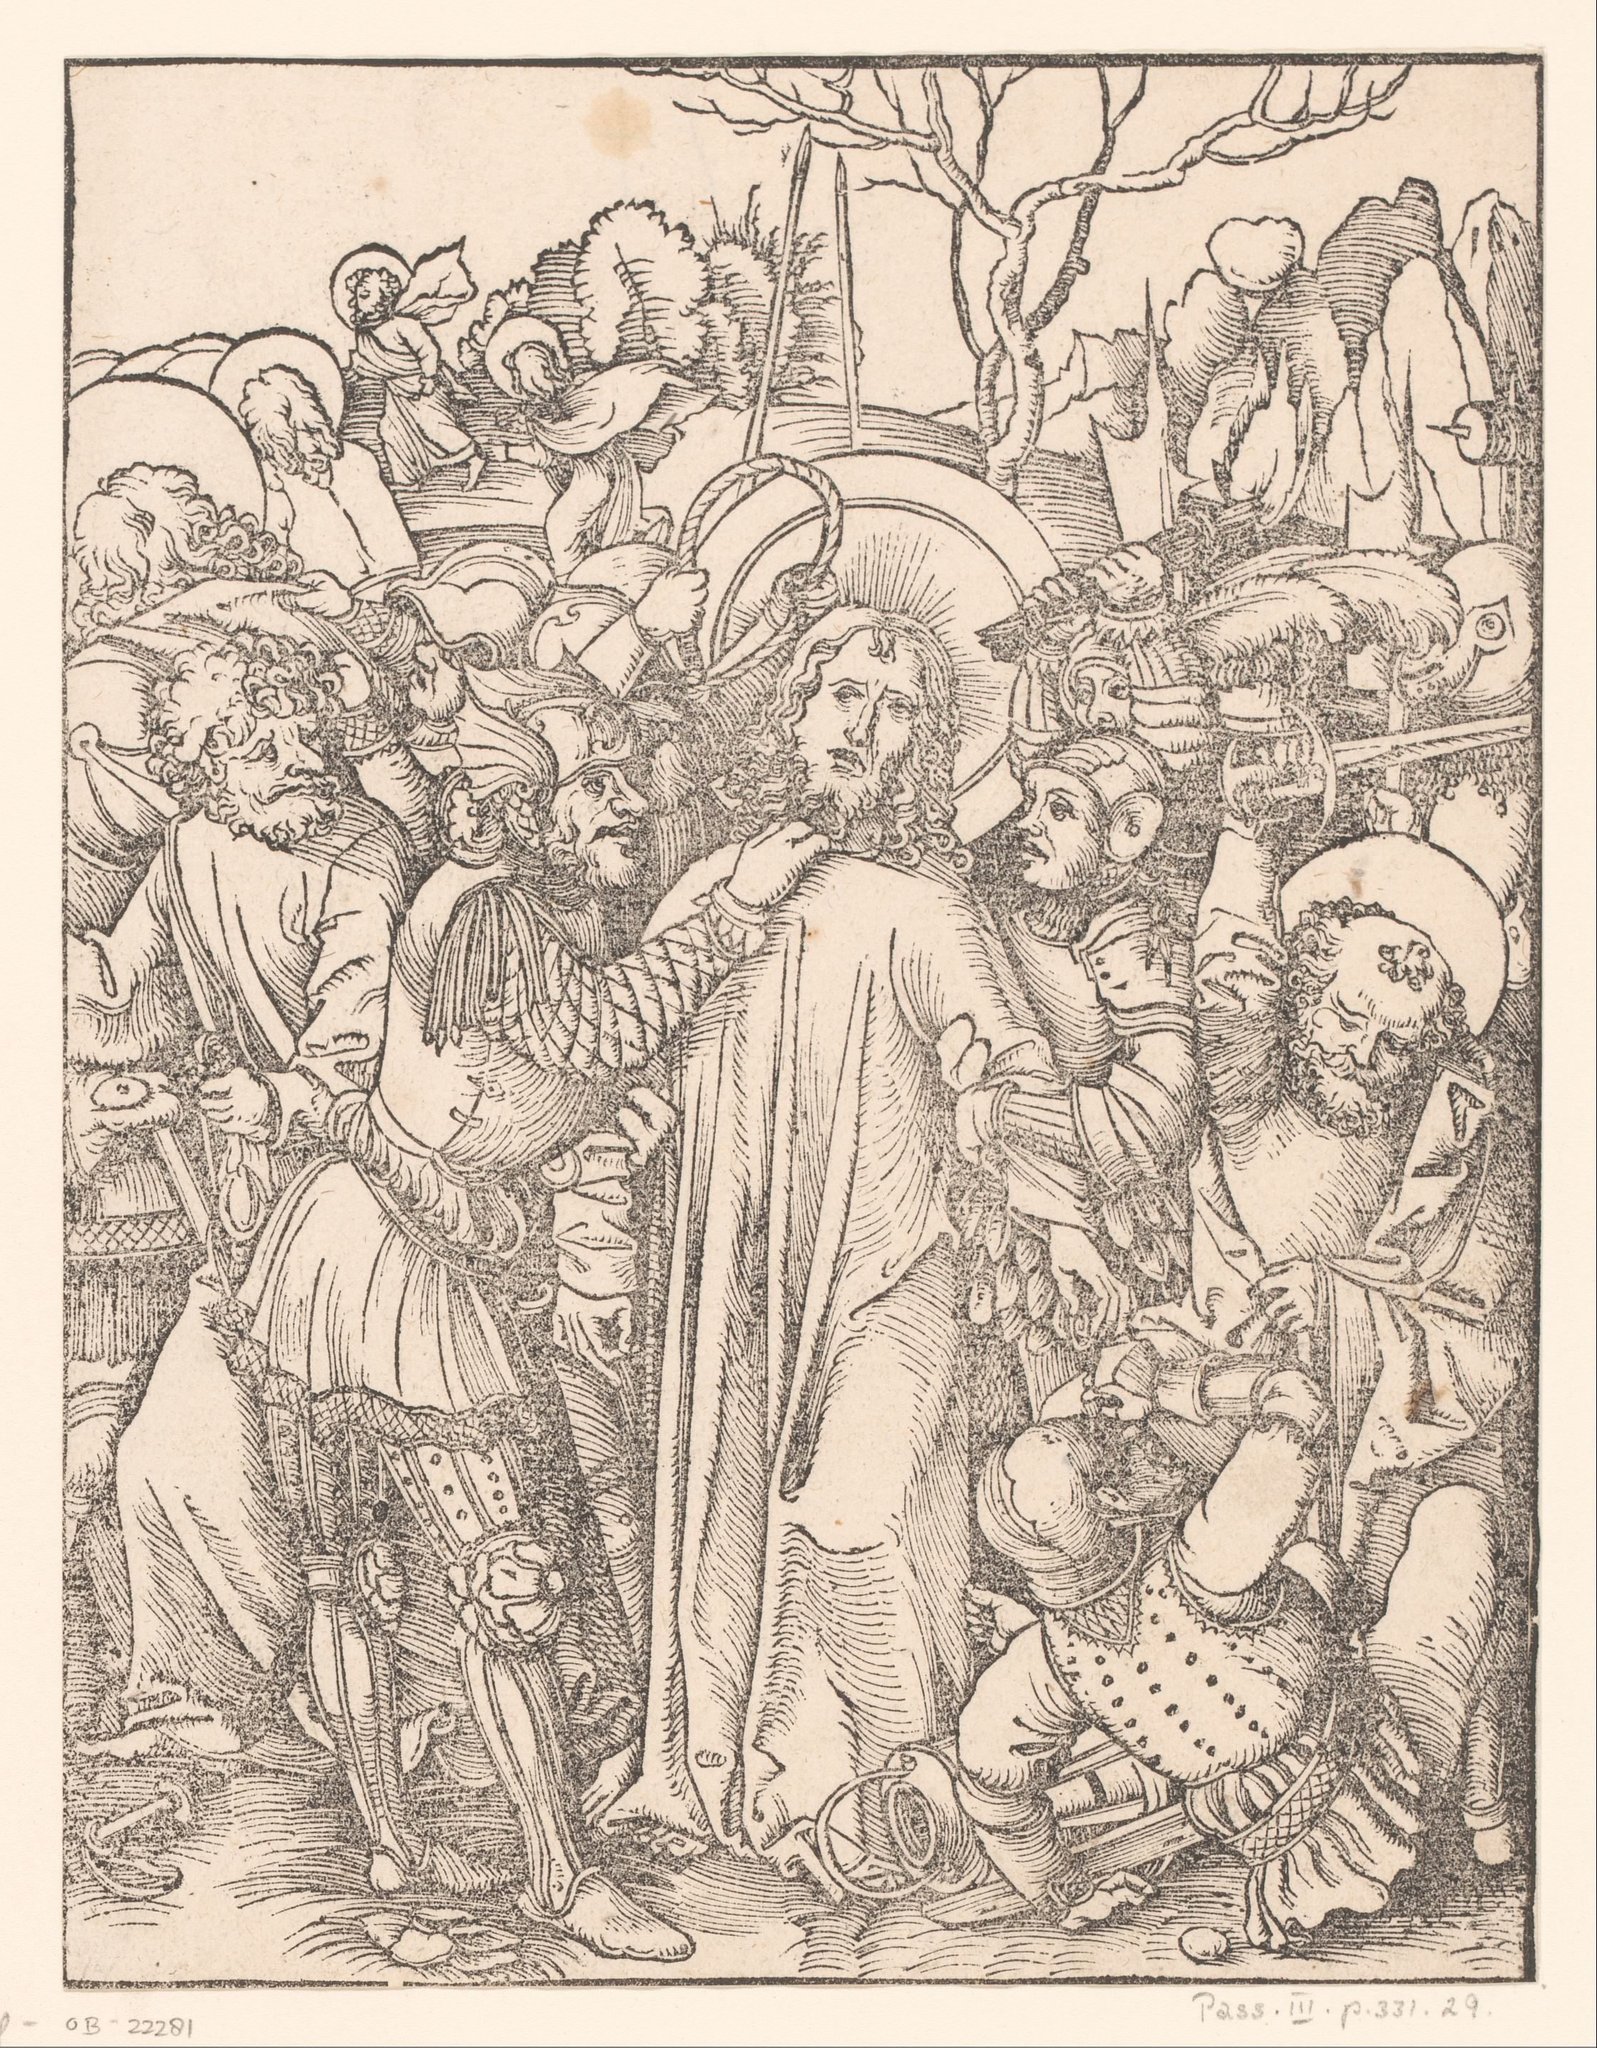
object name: print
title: Gevangenneming van Christus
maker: Anonymous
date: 1490-1526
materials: paper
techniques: woodcut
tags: the arrest of christ ~ garden of gethsemane